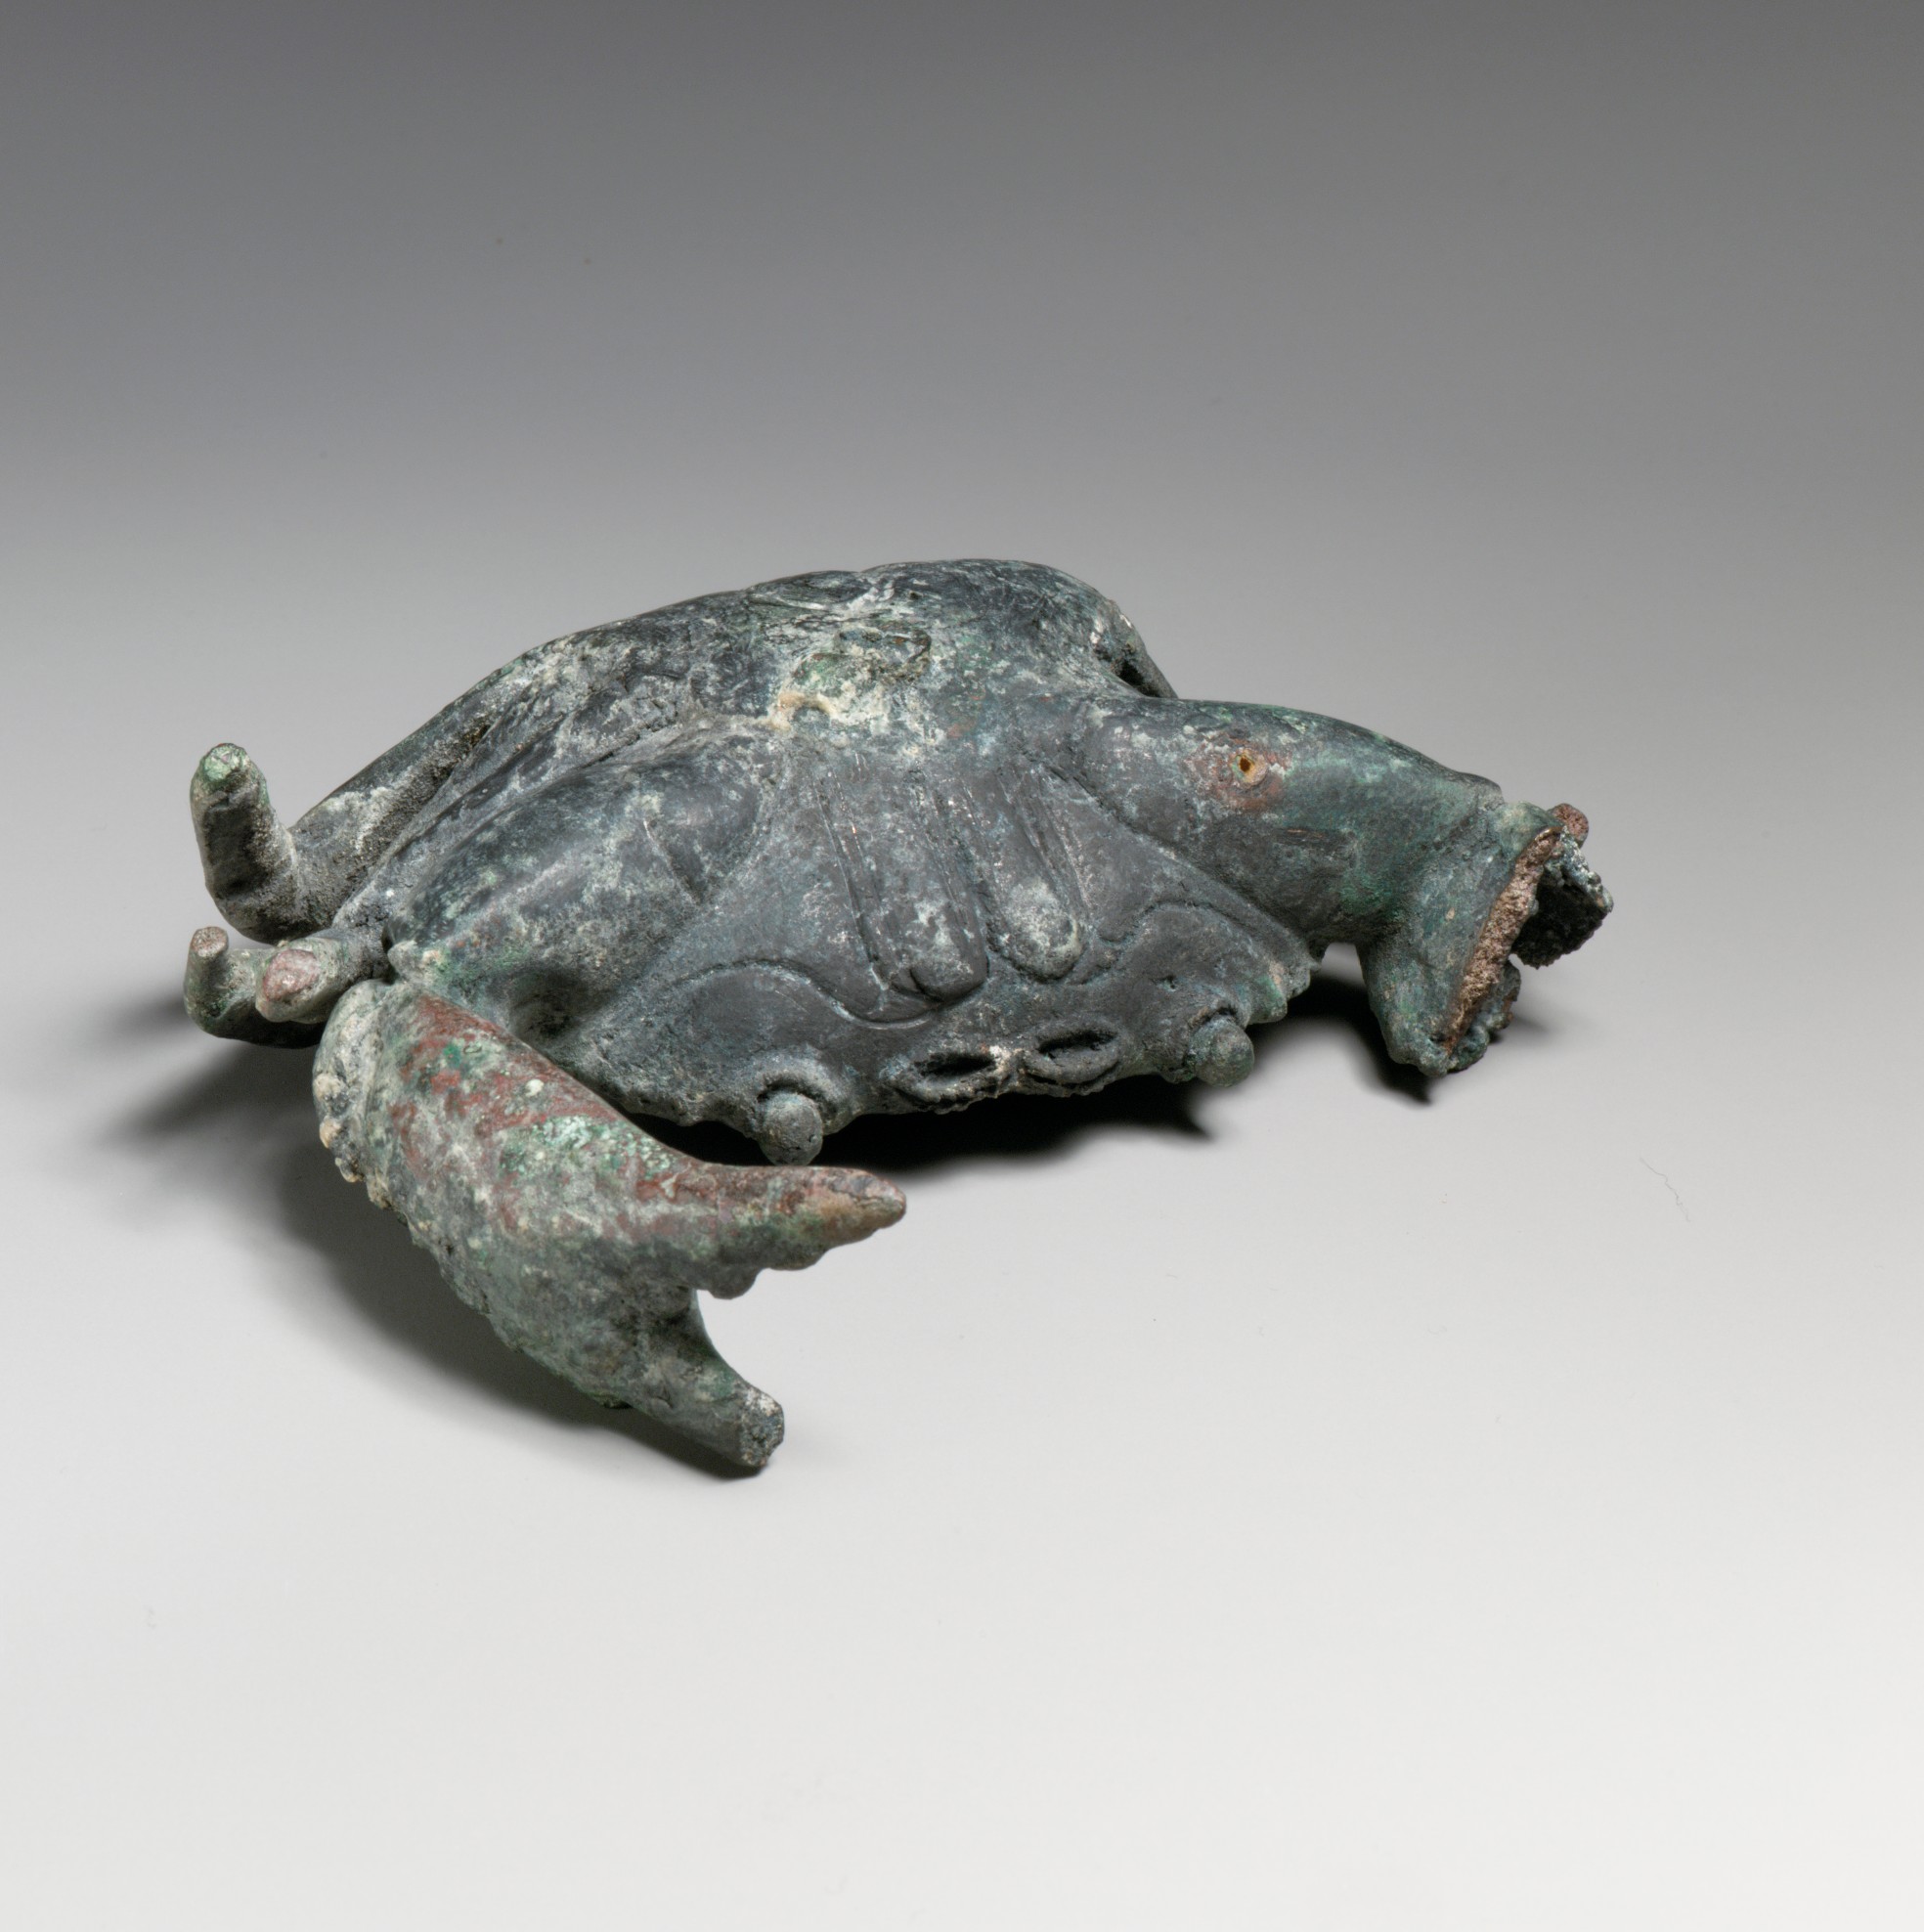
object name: furniture attachment or base in the form of a crab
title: Bronze crab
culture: greek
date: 300-1 BCE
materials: bronze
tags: crabs